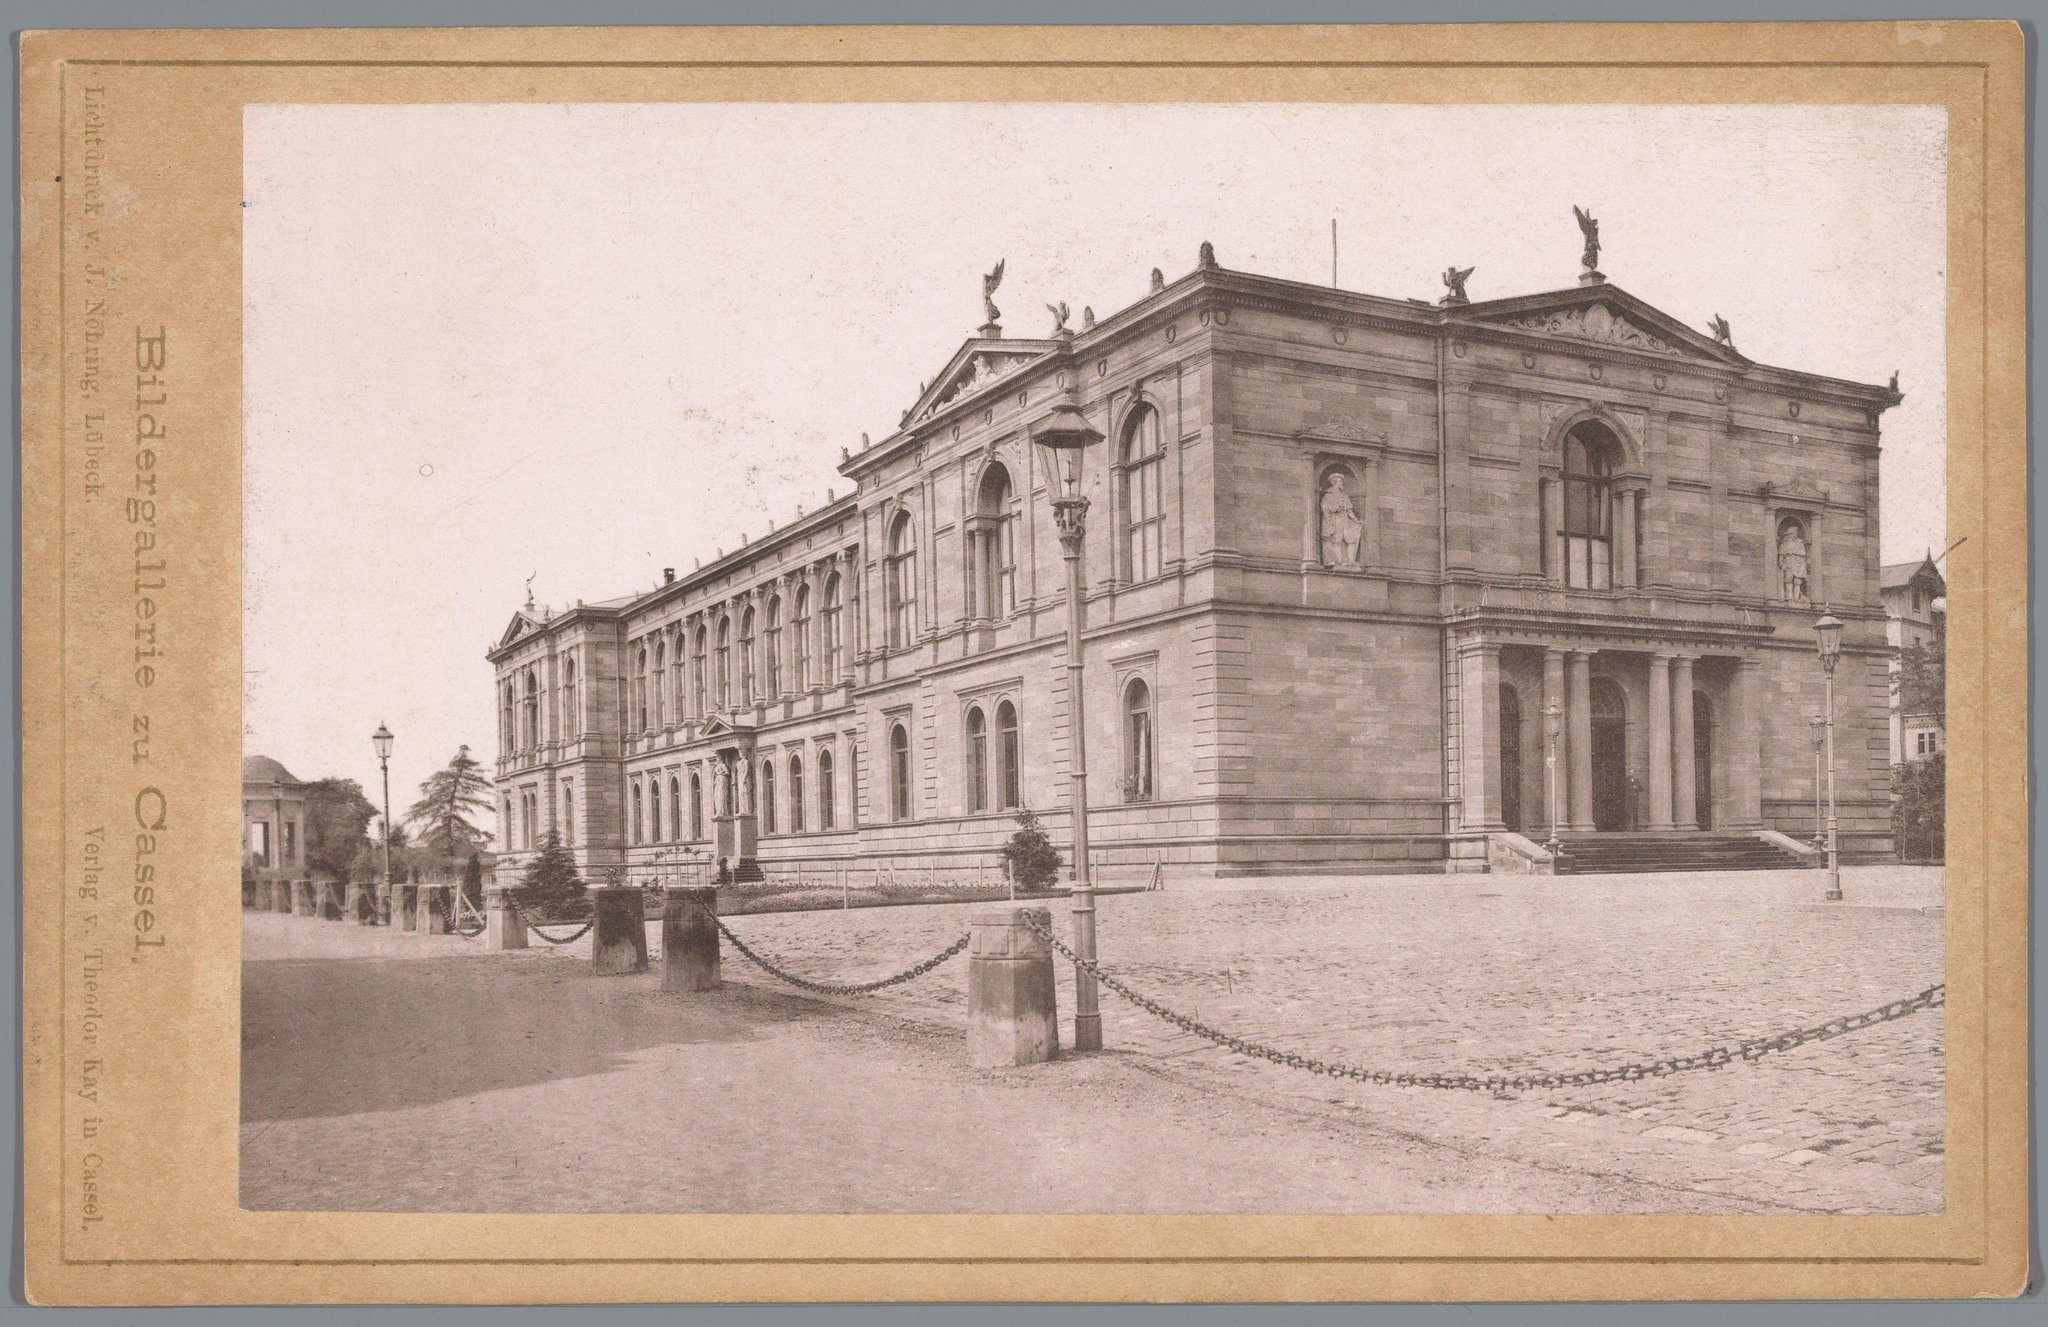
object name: photomechanical print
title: Bildergallerie zu Cassel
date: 1870-1890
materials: cardboard, paper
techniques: photograph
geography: lübeck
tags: permanent exhibition, museum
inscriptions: name: ‘Vosmaer’